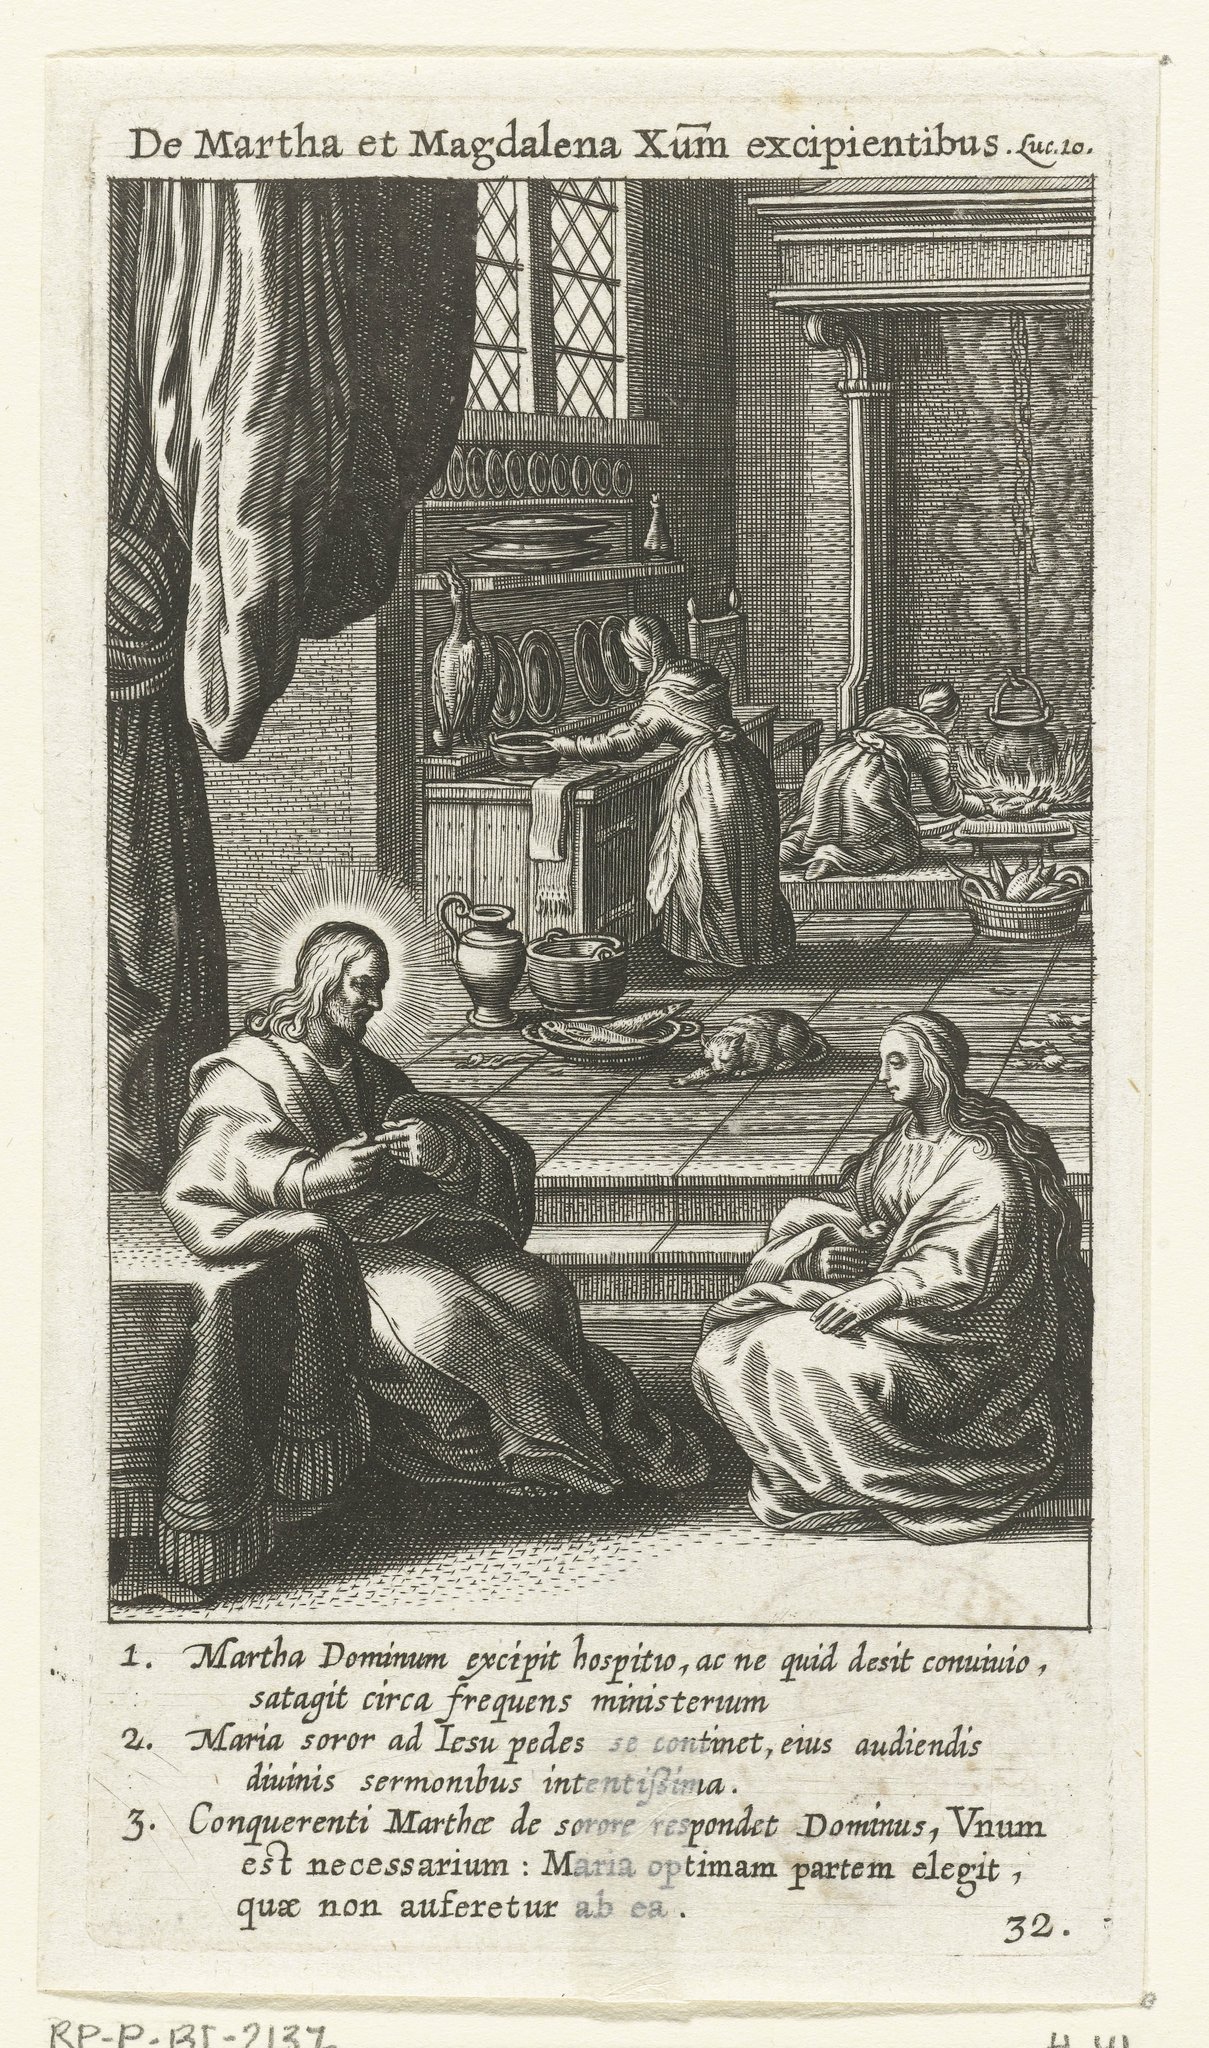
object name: book illustration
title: Christus in het huis van Maria en Martha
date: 1590-1622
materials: paper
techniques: engraving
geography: antwerp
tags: christ in the house of martha and mary (luke 10:38-42)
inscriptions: collector's mark: Lugt 240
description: Prent uit: Joannes Bourgois, Vitae passionis et mortis Jesu Christi Somini nostri mysteria, Antwerpen Hendrick Aertssens, 1622, afb. 32